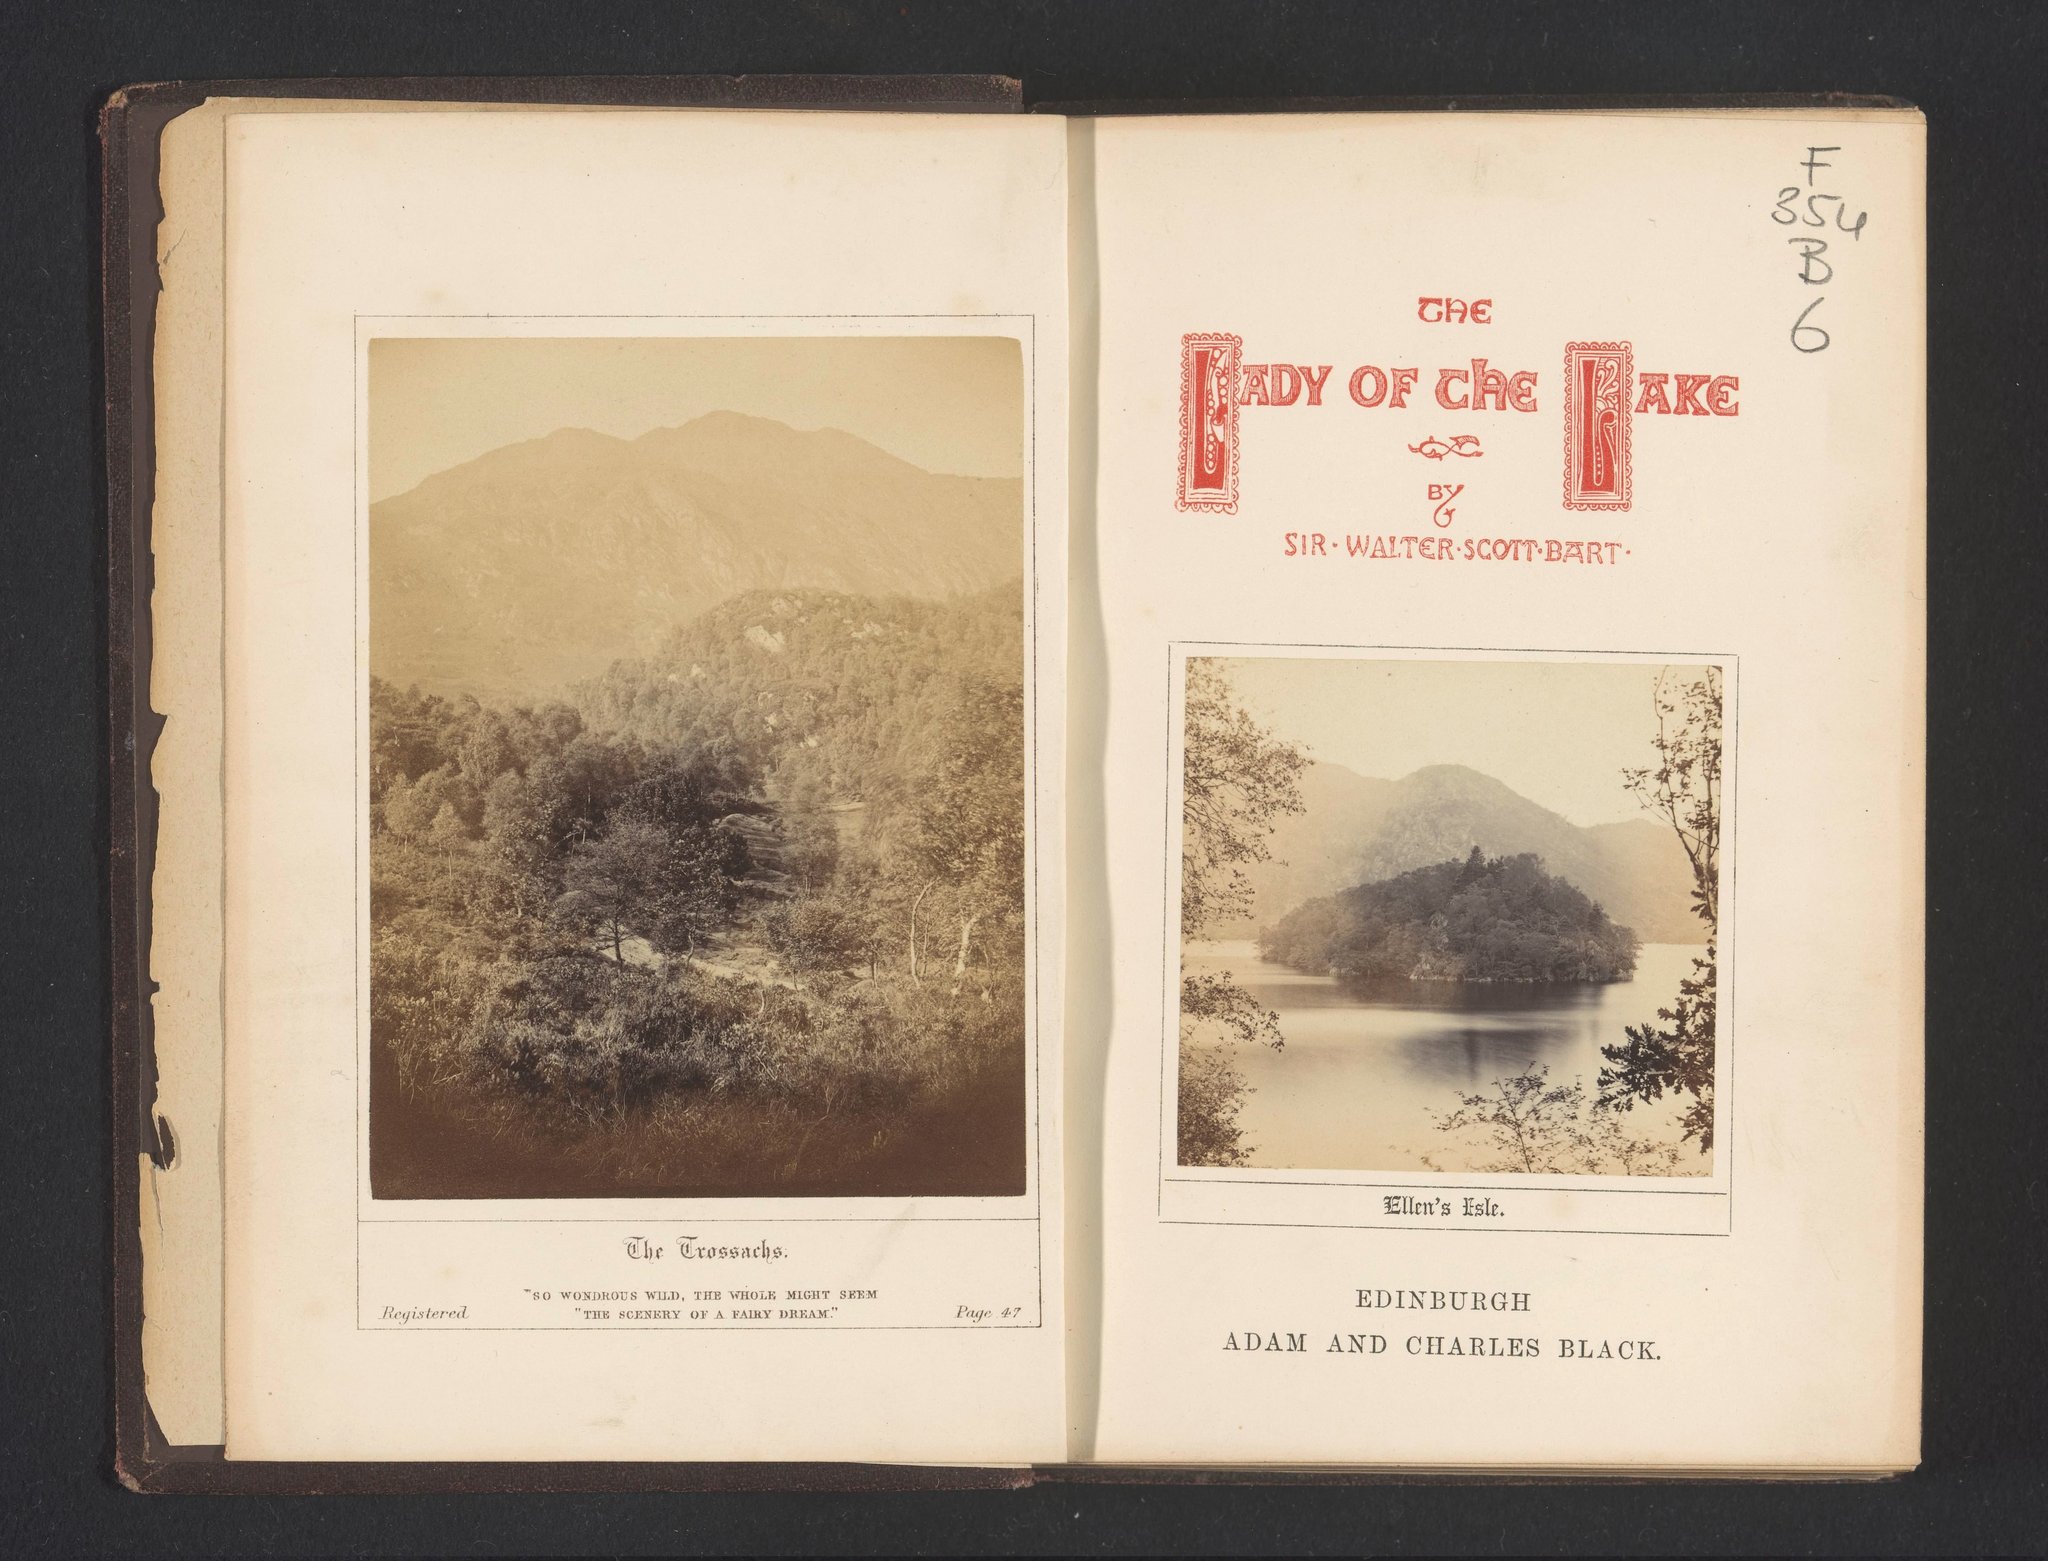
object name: page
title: Ellen's Isle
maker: george washington wilson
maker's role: publisher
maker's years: 1823-1893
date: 1855-1865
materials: photographic support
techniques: albumen print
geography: loch katrine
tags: island, lake